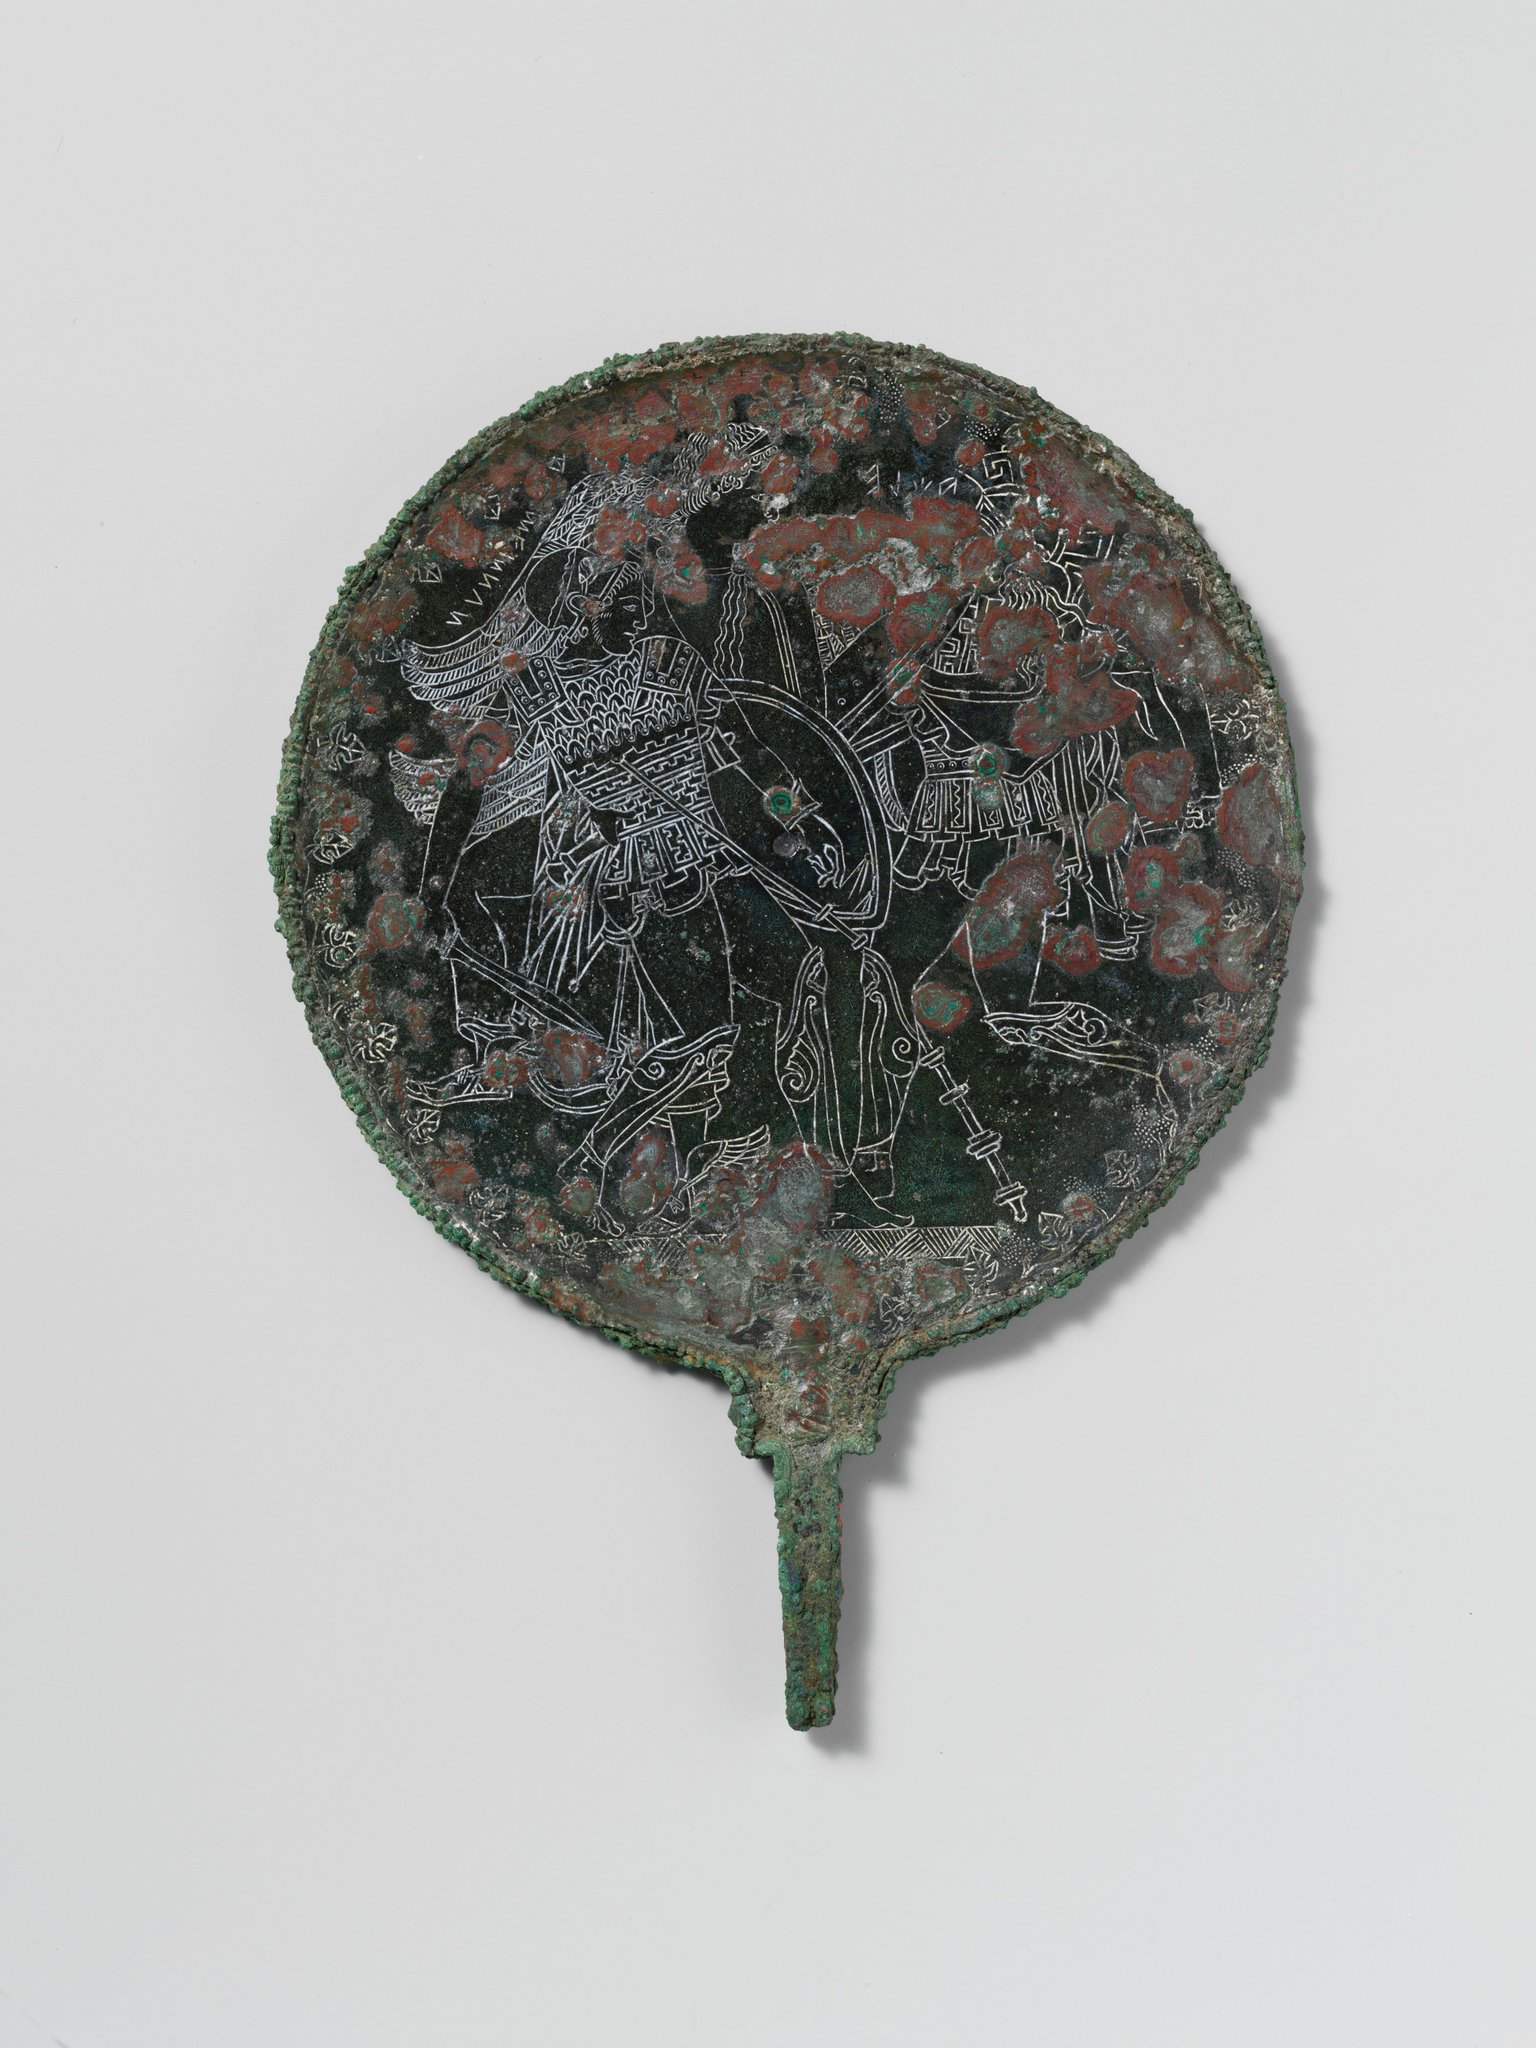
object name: mirror with achilles and memnon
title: Bronze mirror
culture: etruscan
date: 450-420 BCE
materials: bronze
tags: shields,men